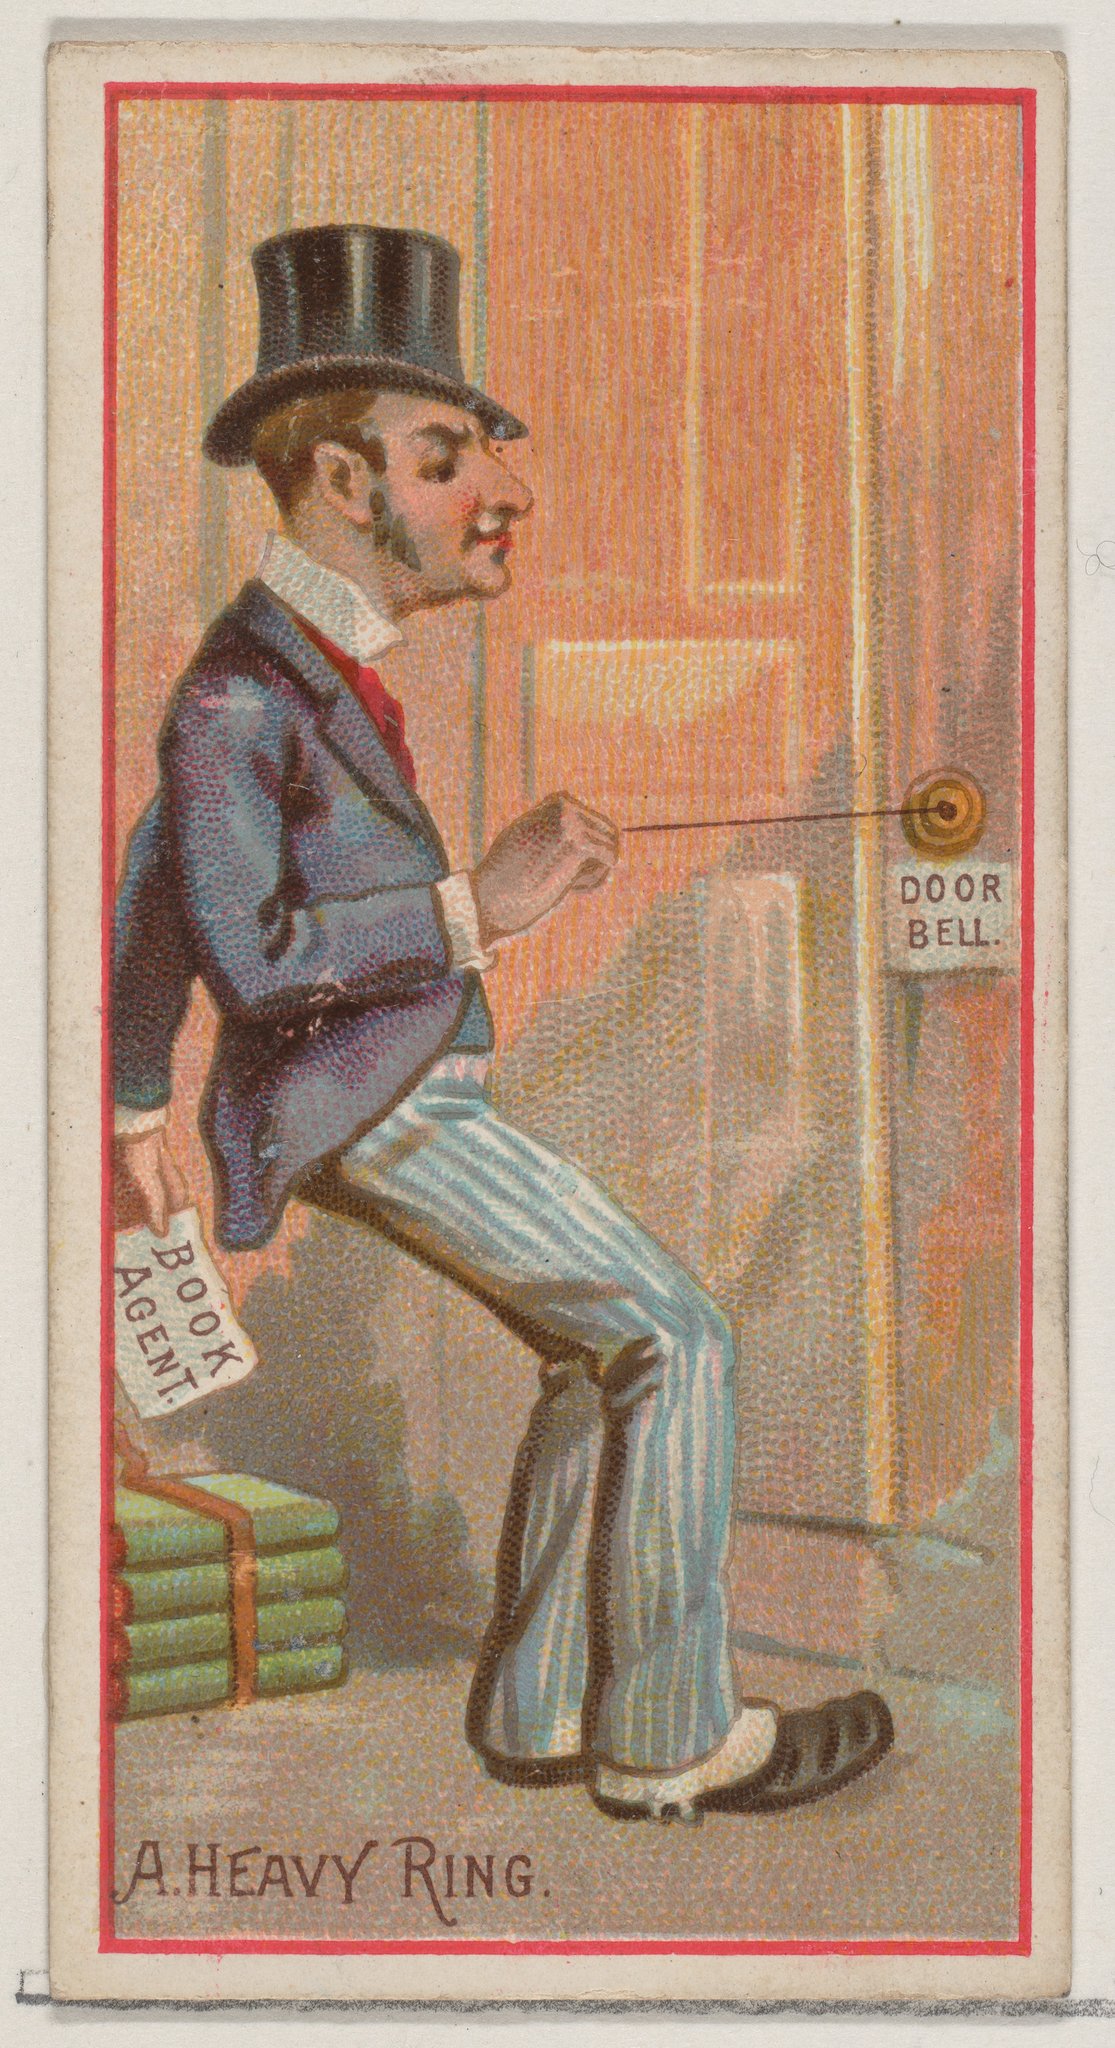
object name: print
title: A Heavy Ring, from the Jokes series (N87) for Duke brand cigarettes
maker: w. duke, sons & co.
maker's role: publisher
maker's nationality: american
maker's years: 1870-1920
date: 1890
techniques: color lithograph